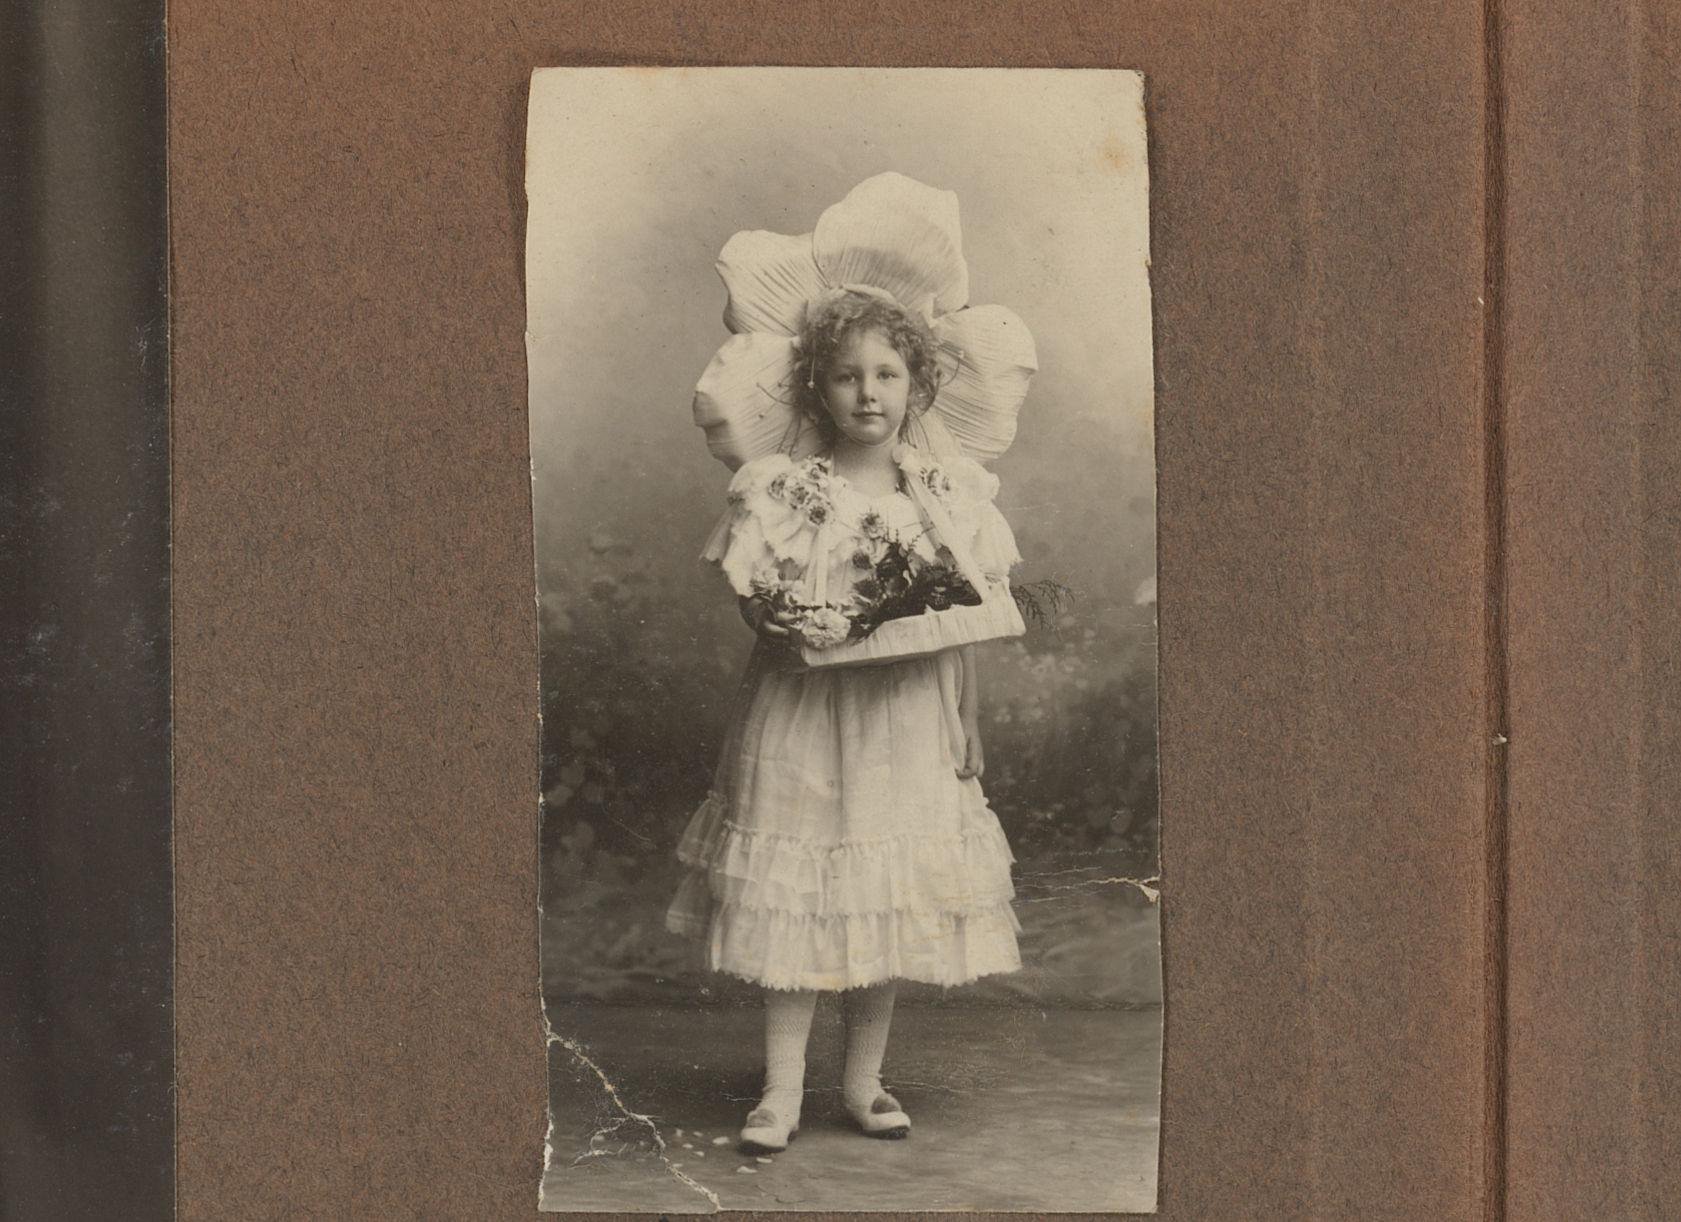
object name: photograph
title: Marietje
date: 1880-1920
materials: photographic support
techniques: photography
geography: netherlands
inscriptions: inscription: ‘Marietje-’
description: Foto op bruin albumblad 26 van familiealbum van Alphons Diepenbrock.